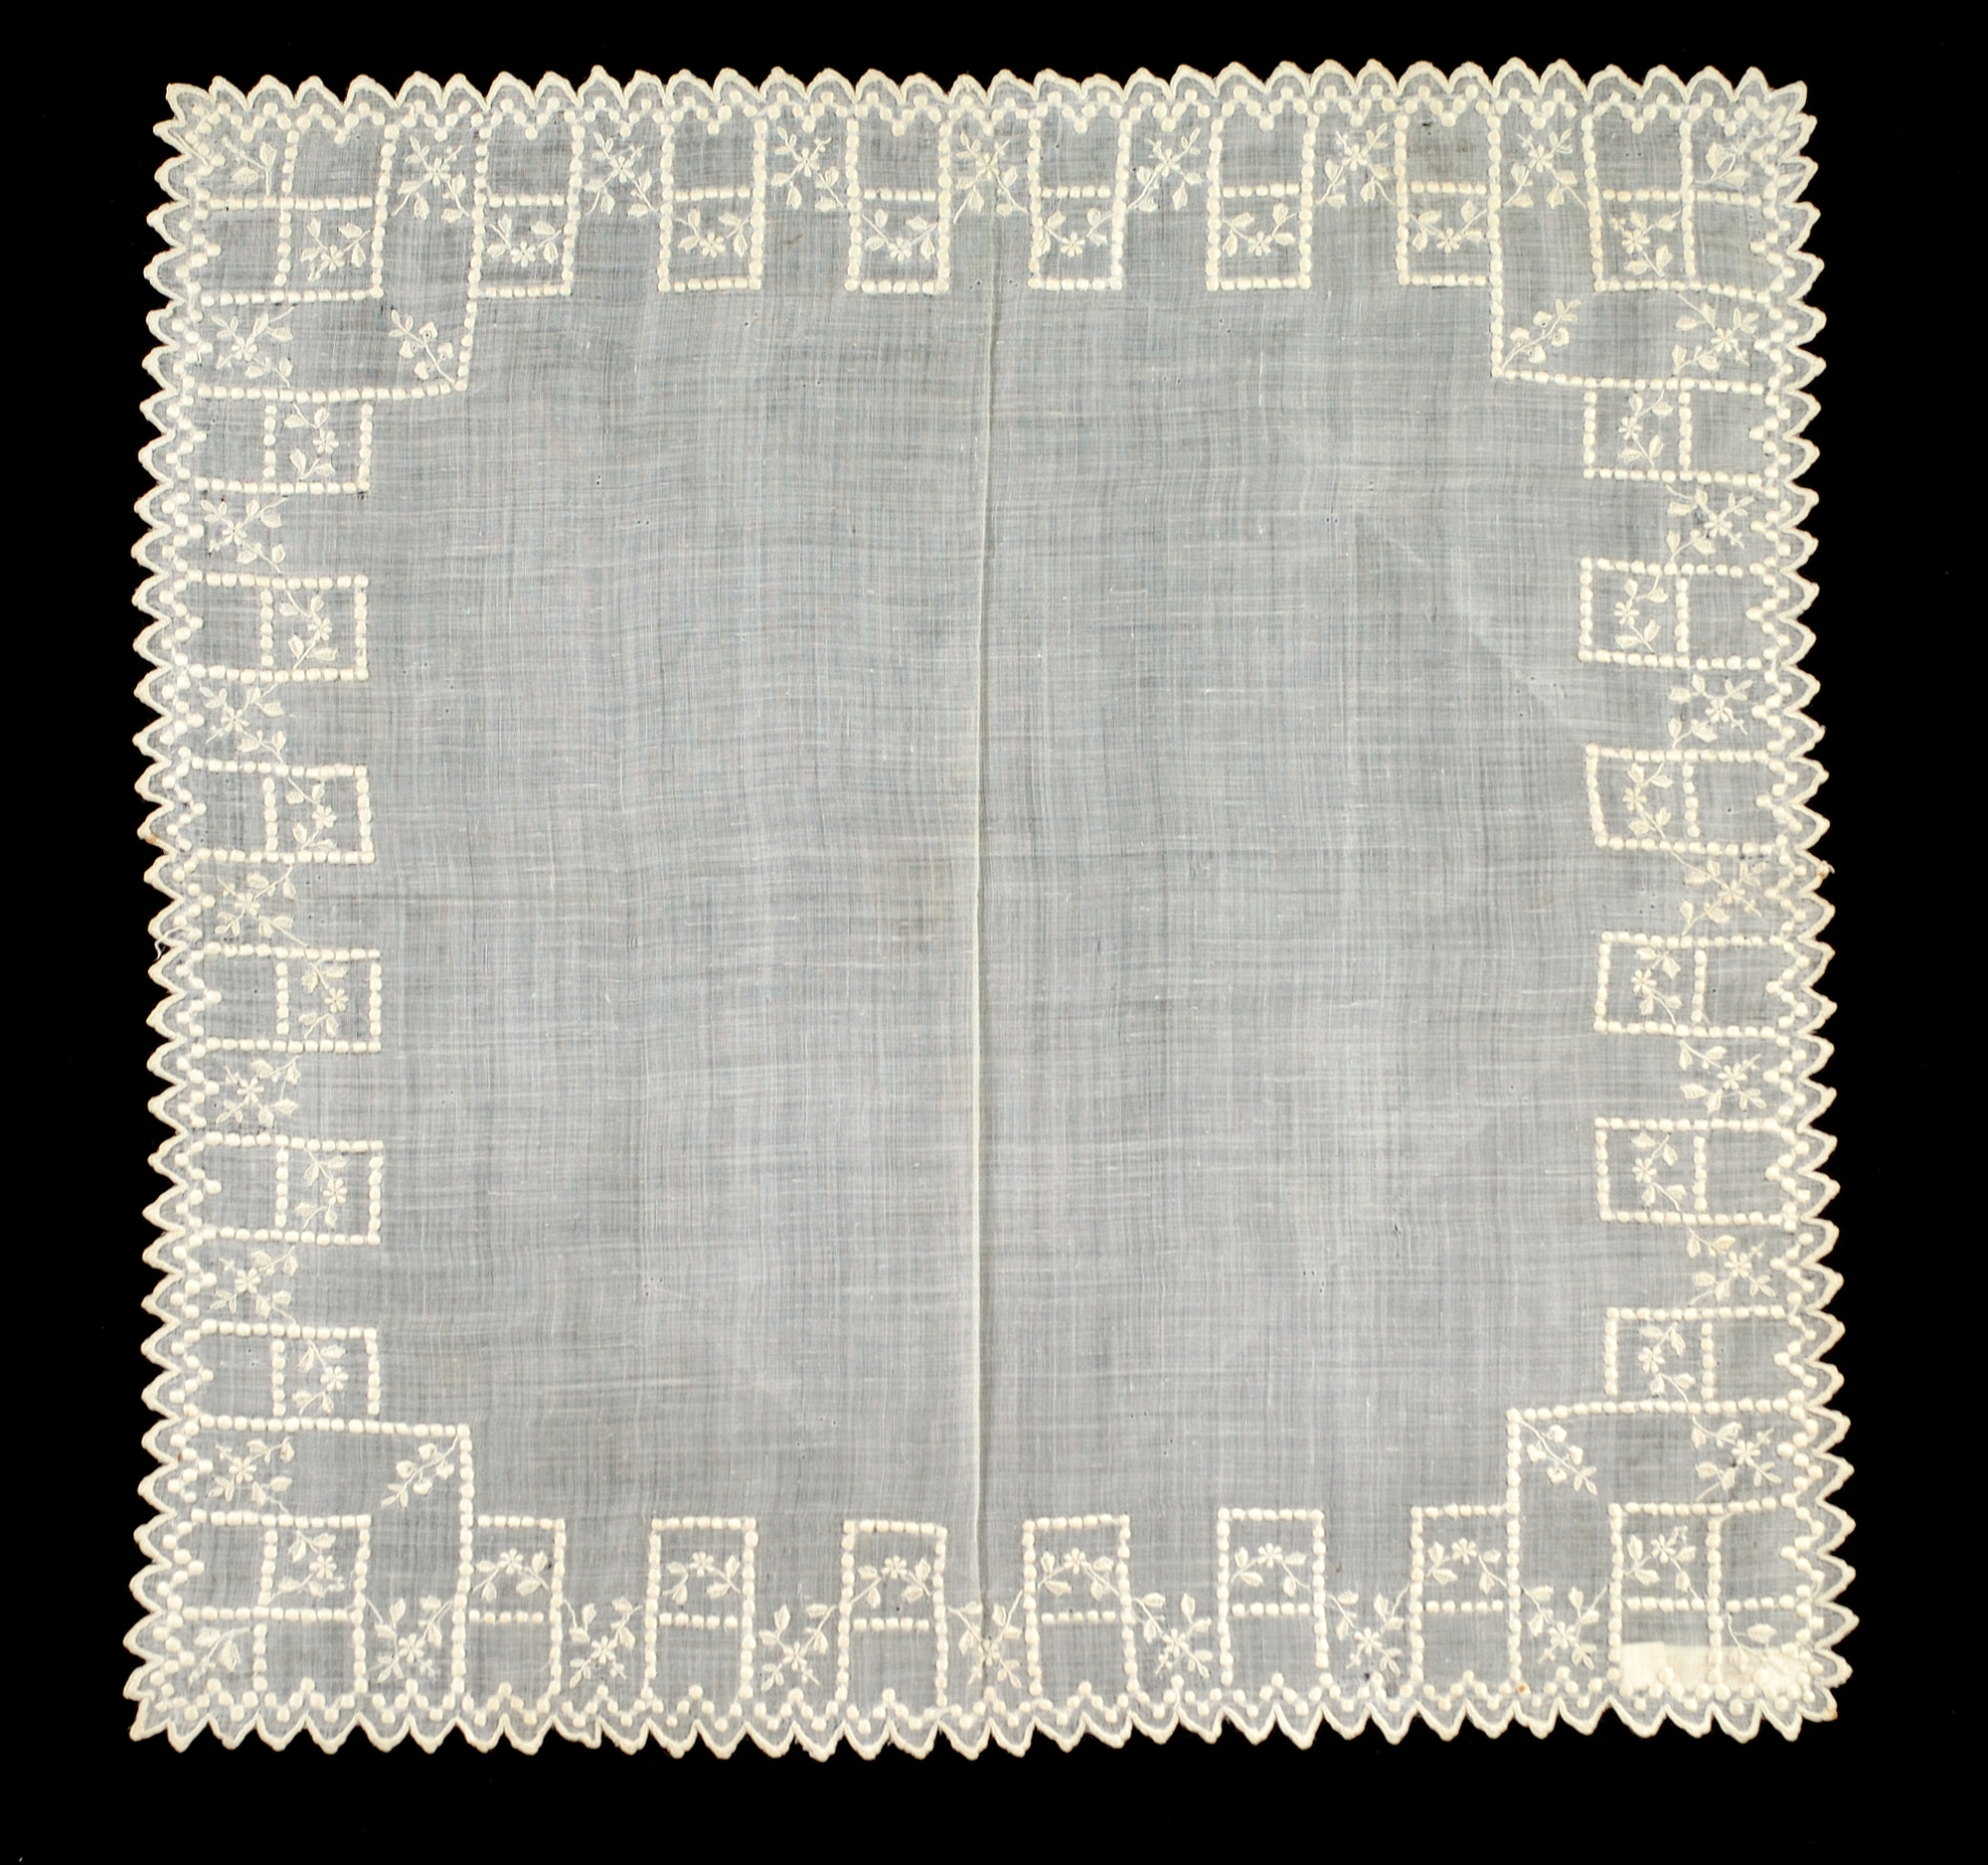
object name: handkerchief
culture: french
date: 1840-1860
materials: cotton